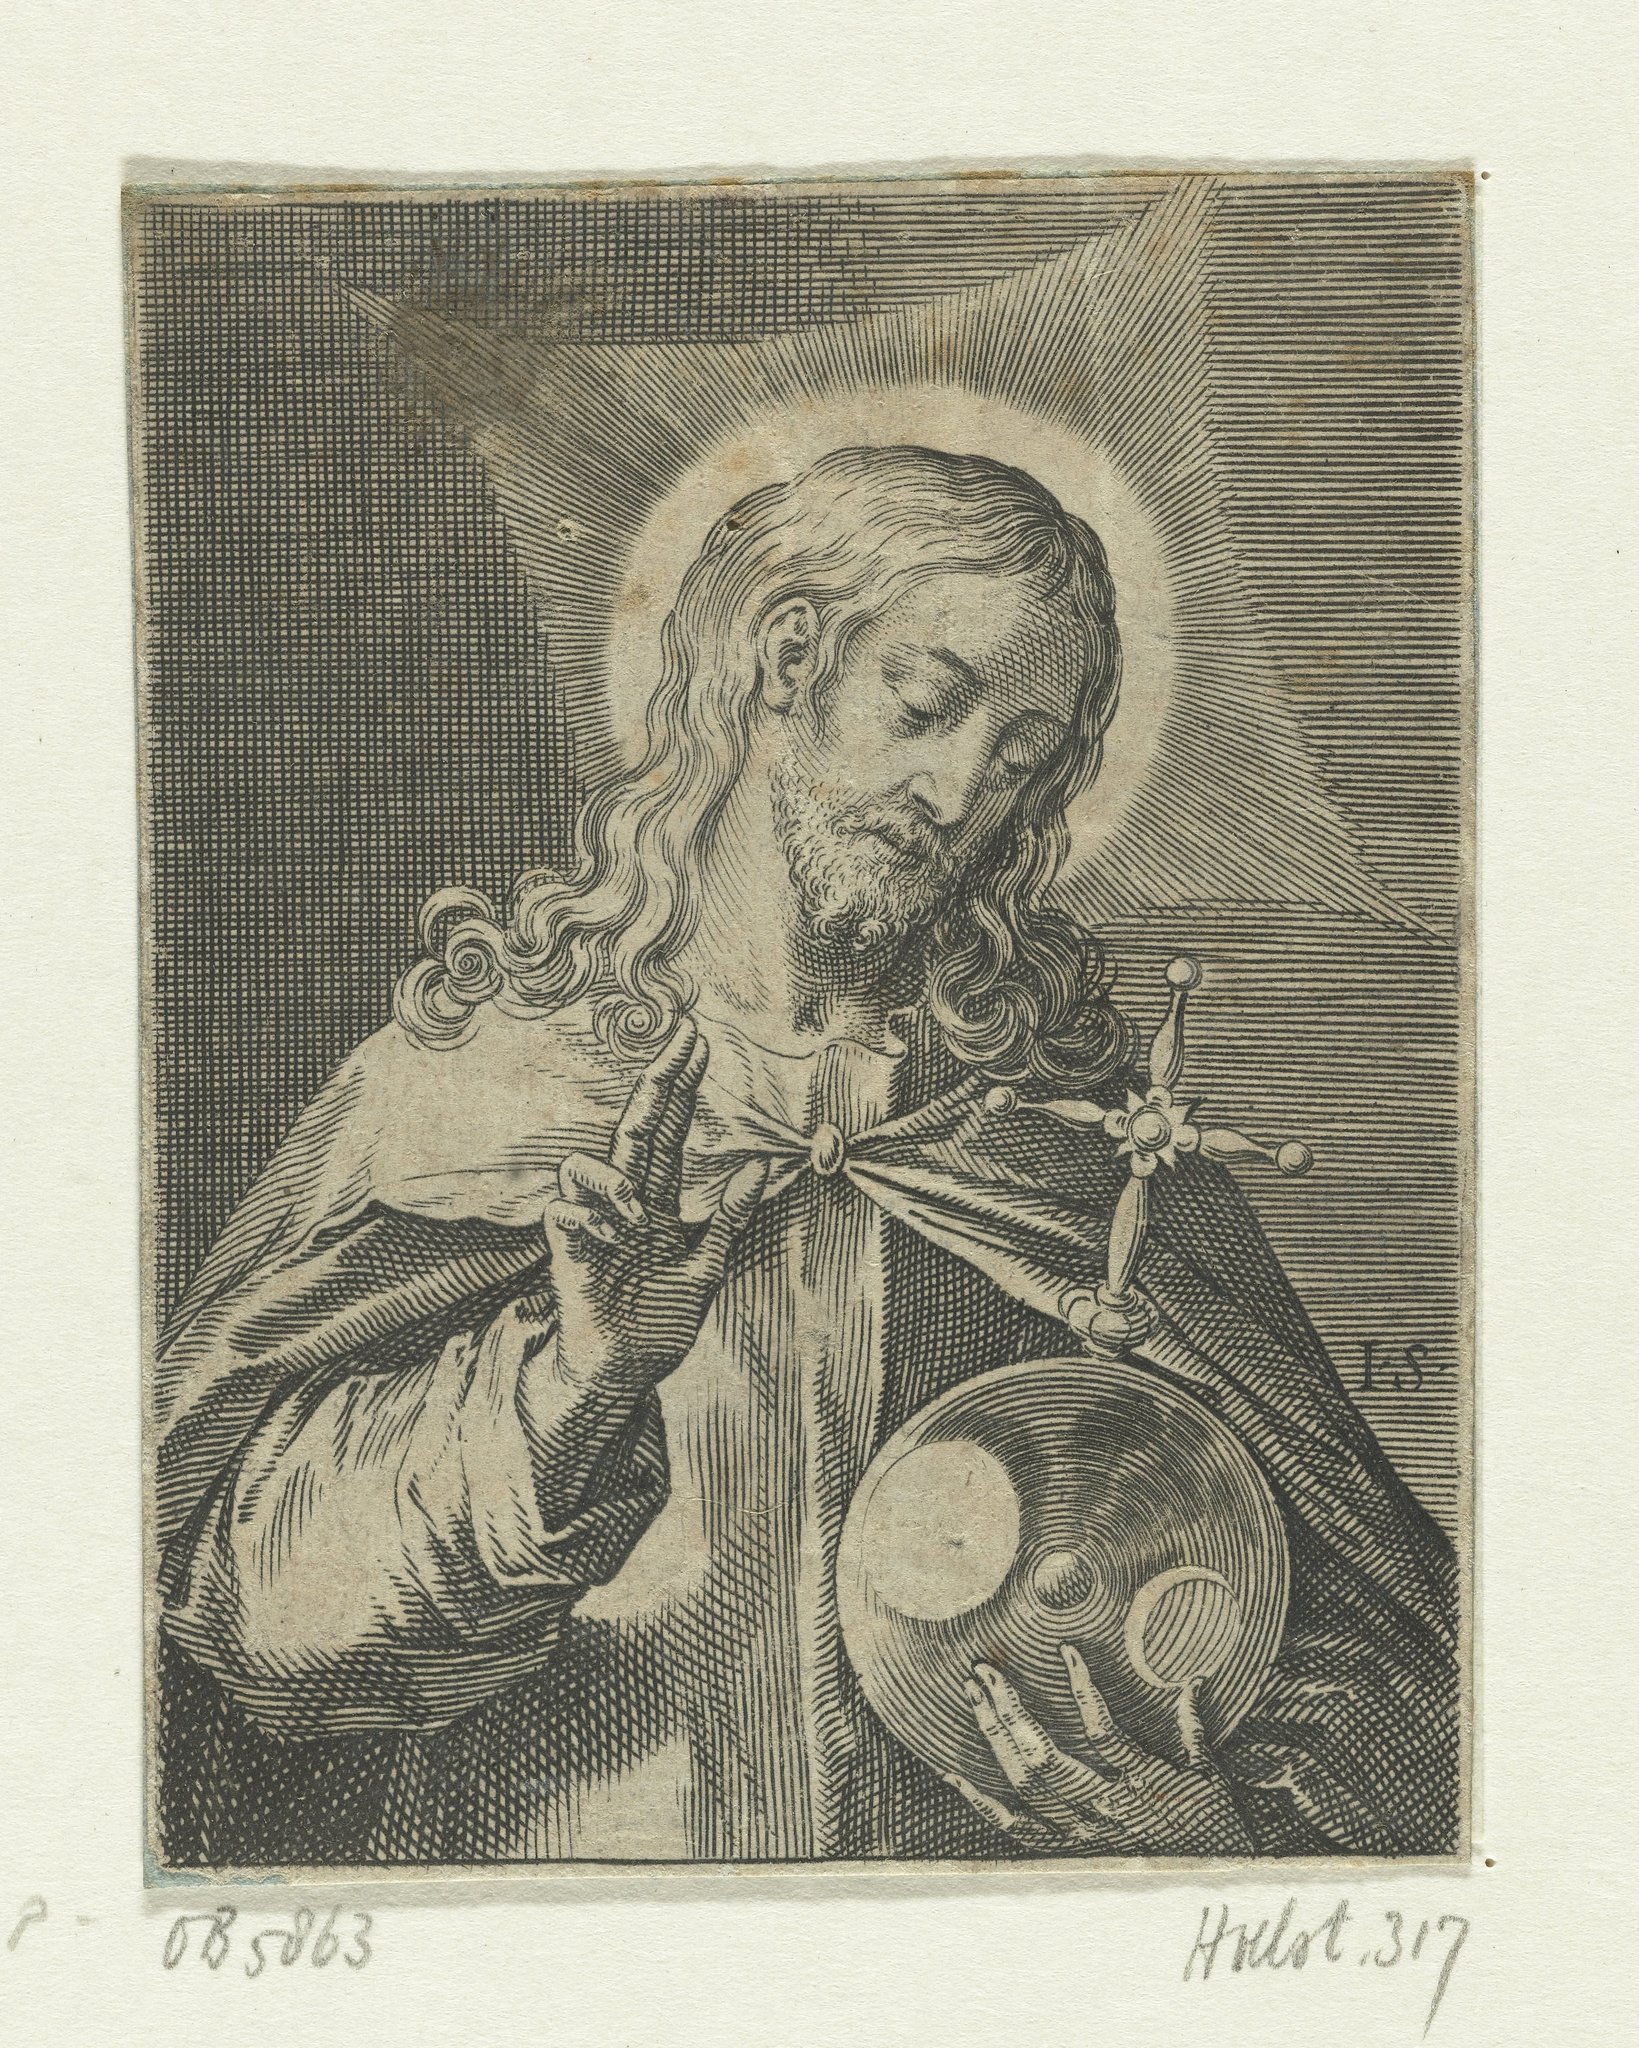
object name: print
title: Christus als Salvator Mundi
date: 1570-1600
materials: paper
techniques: engraving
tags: 'salvator mundi', making a blessing gesture; an orb in his hand or at his feet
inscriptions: collector's mark: Lugt 240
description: Christus als Salvator Mundi. Hij houdt de rijksappel vast en maakt een zegenend gebaar. De eerste prent in een serie van veertien waarvan de prenten met een apostel genummerd zijn van 1 tot 12.